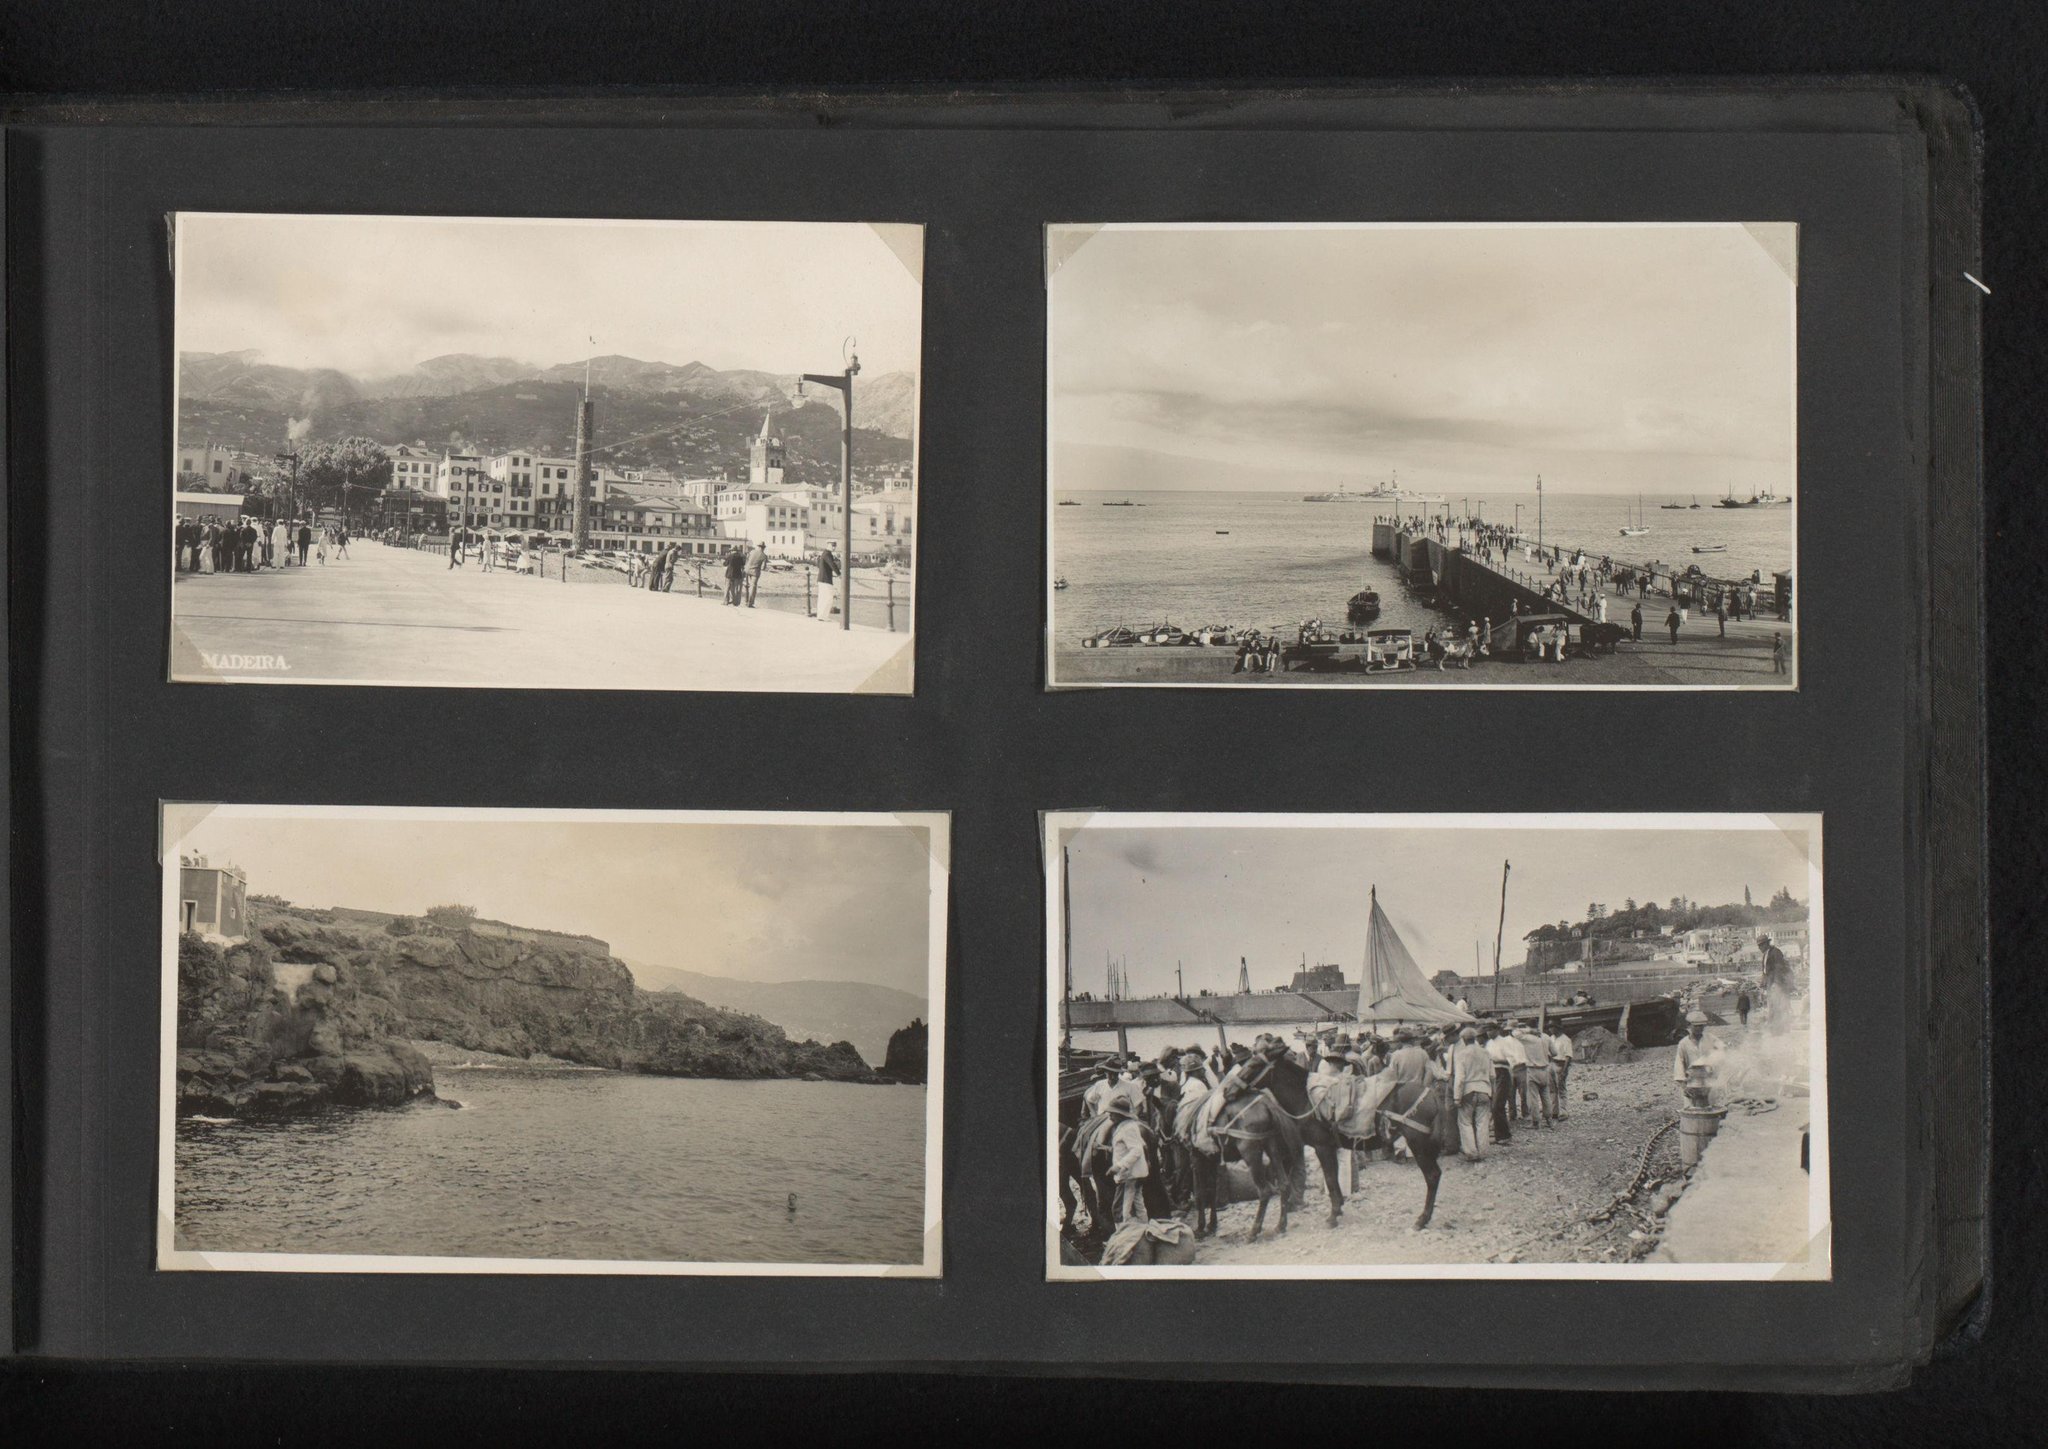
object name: ansichtkaart, prentbriefkaart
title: Vier foto's, waarvan een prentbriefkaart, van Madeira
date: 1933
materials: paper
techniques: gelatin silver print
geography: madeira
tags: carel frederik van den berg (cay), harbour, city-view in general; 'veduta'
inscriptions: inscription: ‘6. aanlegplaats te Funchal/ 7 rotsen bij Gurgulho/ (Cay zwemmende)/ 8 aan het strand te Funchal/ Madeira’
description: Deze foto's maken deel uit van een album.